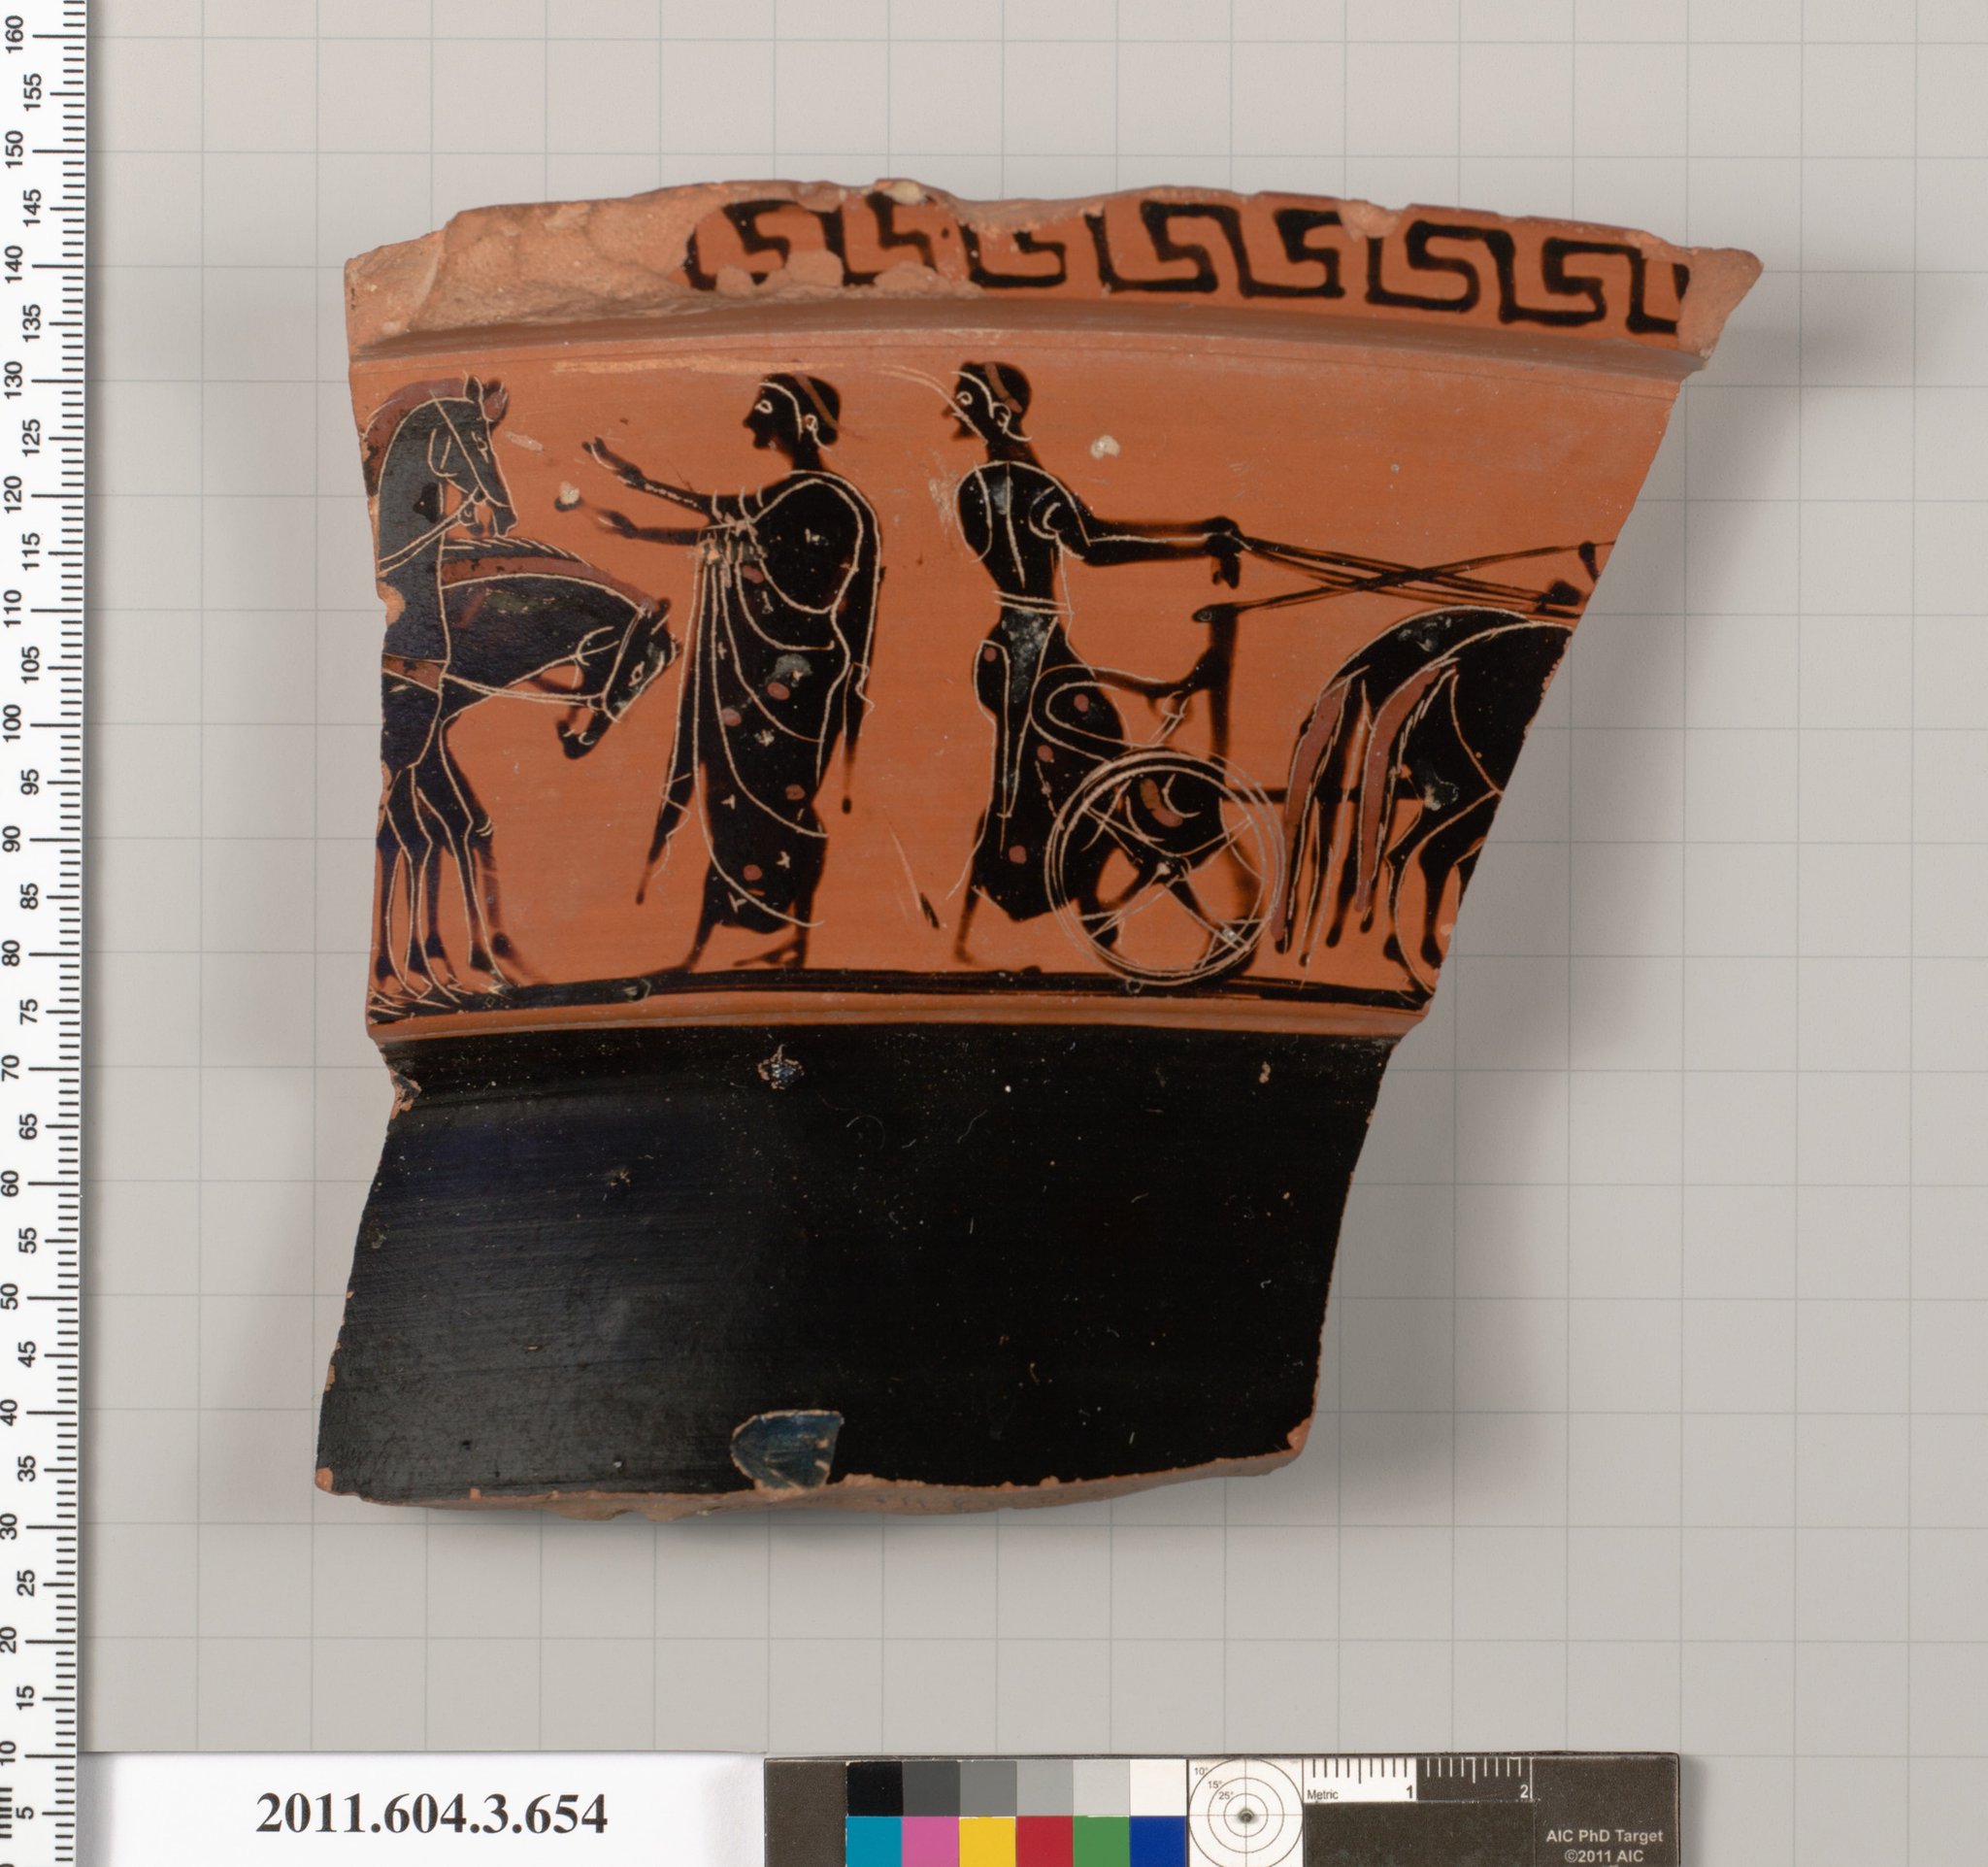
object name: volute krater fragment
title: Terracotta fragment of a volute-krater (bowl for mixing wine and water)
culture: greek, attic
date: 500 BCE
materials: terracotta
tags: horses,chariots